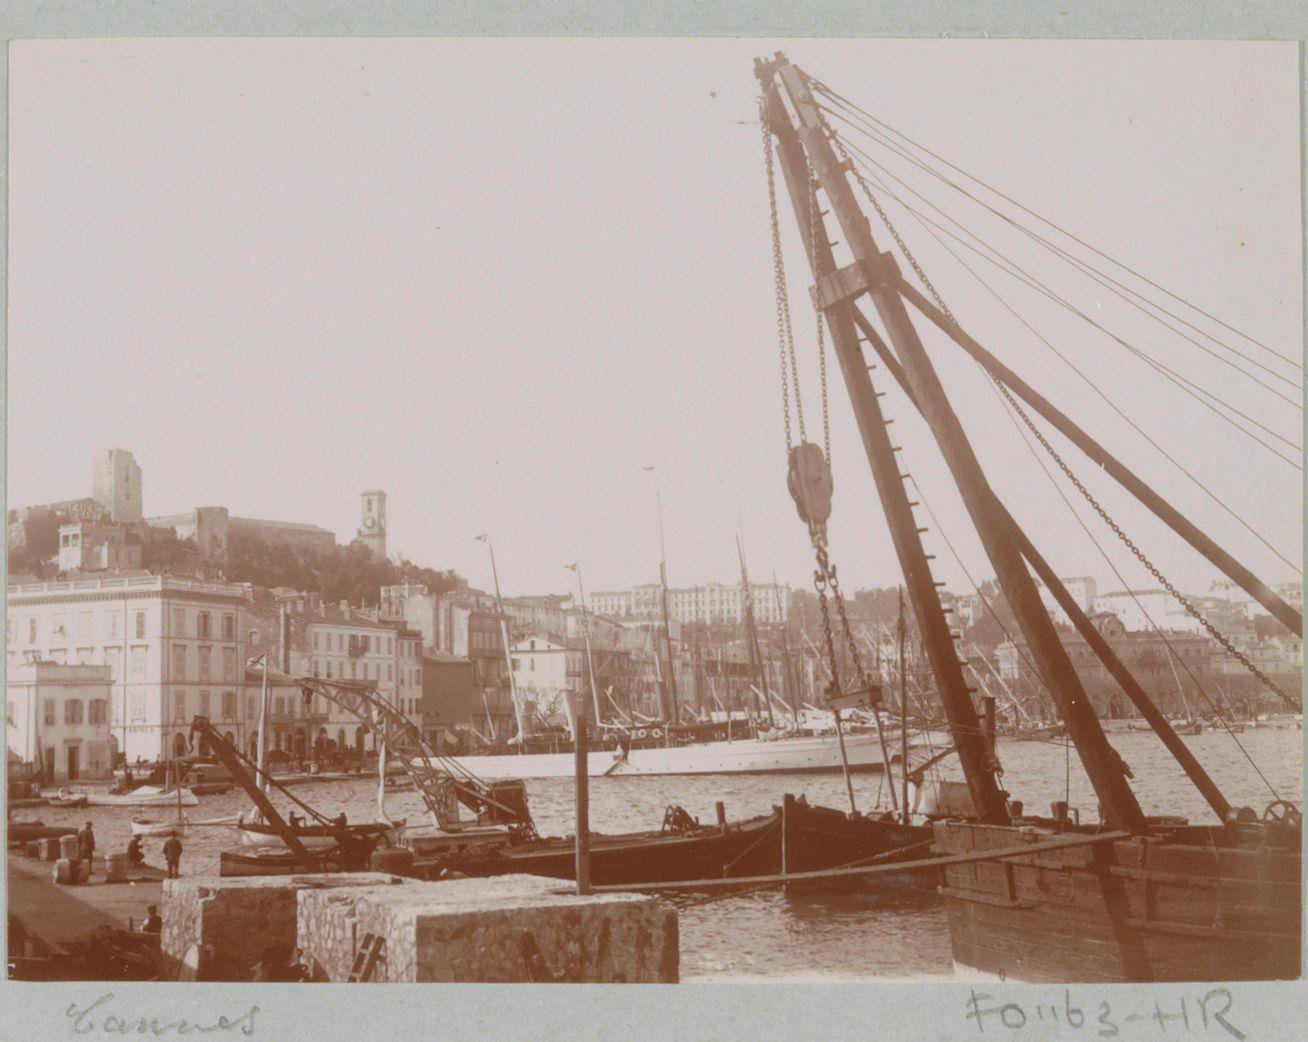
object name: photograph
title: Gezicht op de haven van Cannes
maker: delizy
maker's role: manufacturer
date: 1899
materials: paper, photographic support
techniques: gelatin silver print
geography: cannes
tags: harbour (+ view ~ vehicle, ship, etc.)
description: Onderdeel van Fotoalbum van een Franse amateurfotograaf met opnames van uitstapjes in Frankrijk, Spanje, België, Luxemburg en Nederland, de eerste automobielen en autoraces.